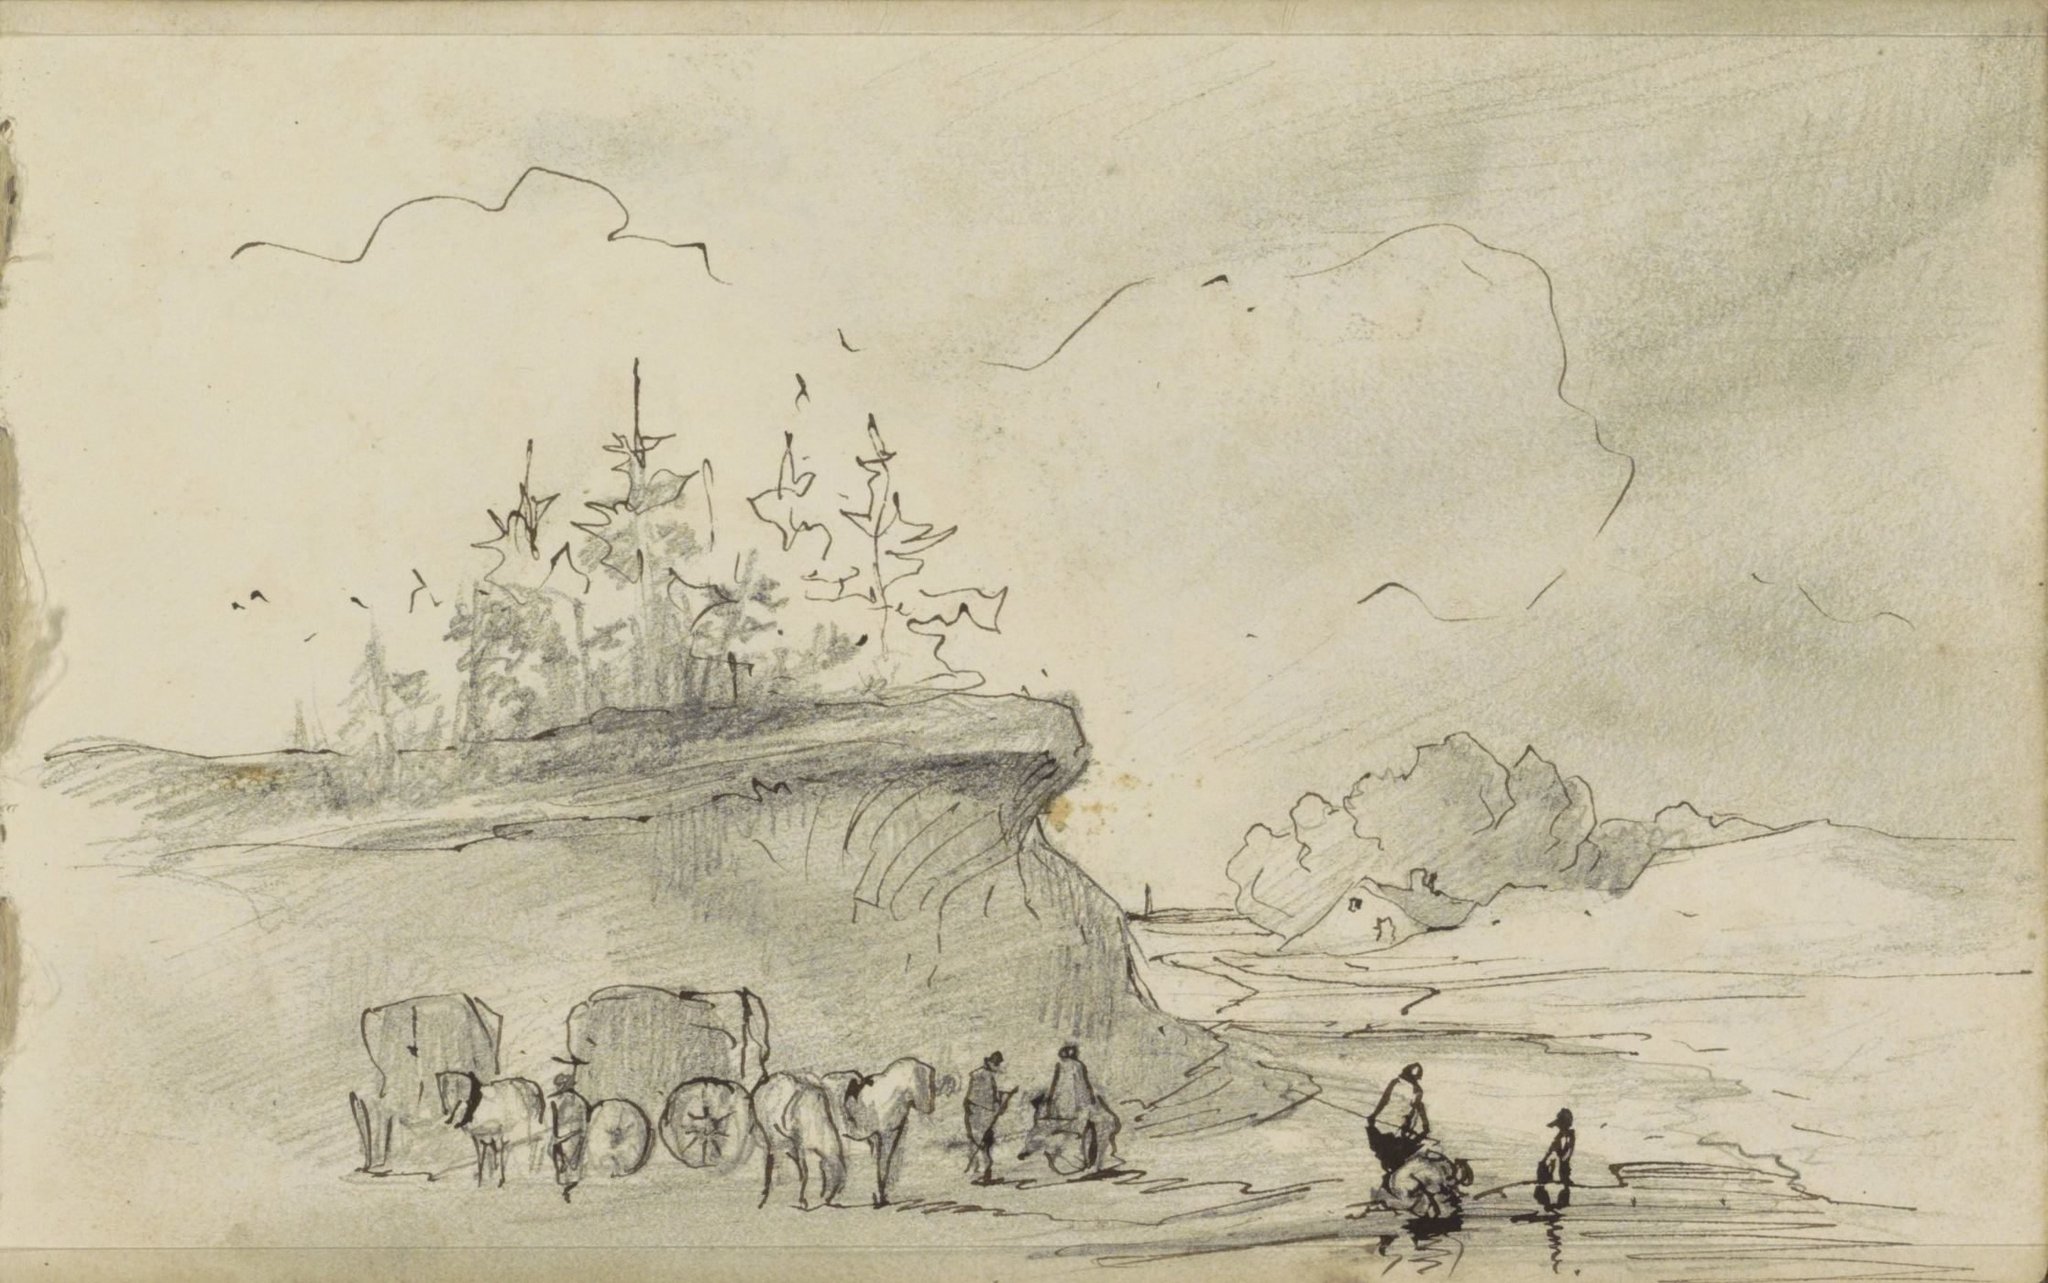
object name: sketchbook leaf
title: Landschap met paarden en karren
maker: johannes tavenraat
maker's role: draughtsman, painter, print maker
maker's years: 1809-1881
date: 1839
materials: paper, pencil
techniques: pen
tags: trees, four-wheeled, animal-drawn vehicle, e.g.: cab, carriage, coach, landscapes (+ landscape with figures, staffage)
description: Met enkele figuren op de voorgrond. Op de achtergrond een huis, mogelijk een boerderij. Blad 18 recto uit een schetsboek met 37 bladen.